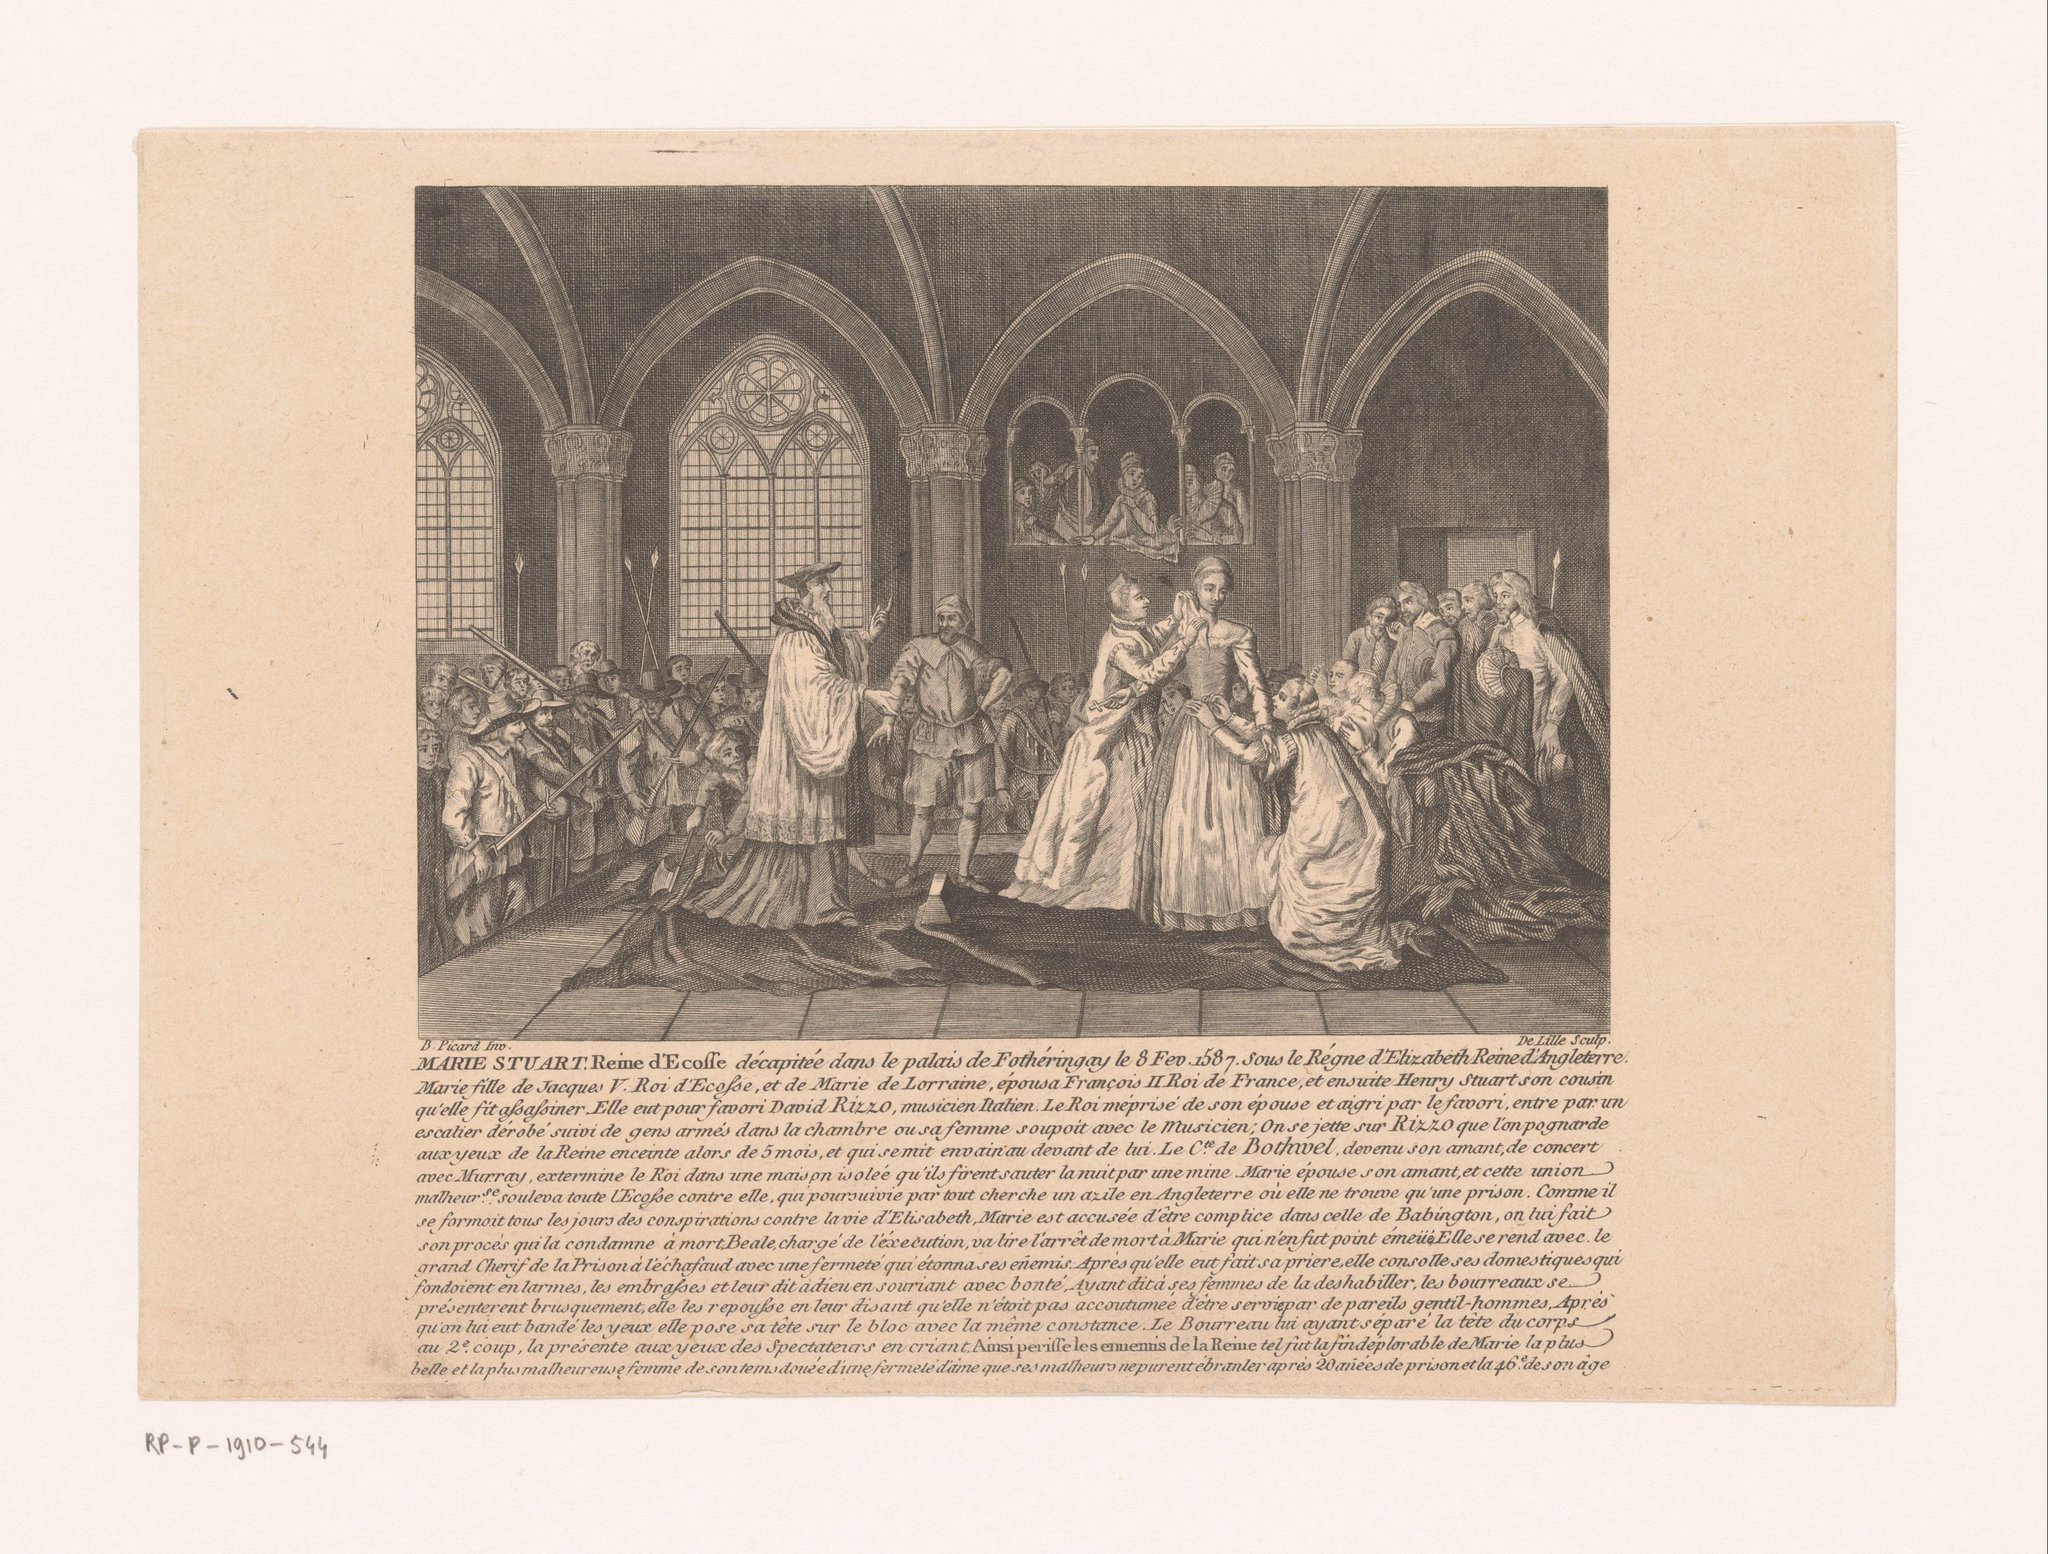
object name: print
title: Maria I Stuart wordt geblinddoekt om onthoofd te worden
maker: bernard picart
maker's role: draughtsman, print maker, publisher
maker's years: 1673-1733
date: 1768-1823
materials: paper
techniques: etching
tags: historical persons, violent death by beheading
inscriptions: collector's mark: Lugt 2228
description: Maria I Stuart, koningin van Schotland, wordt door twee hofdames geblinddoekt. Ze wordt onthoofd op bevel van koningin Elisabeth I van Engeland. Een priester spreekt haar toe. De beul staat klaar op het schavot. Een jongen geeft hem de bijl aan.